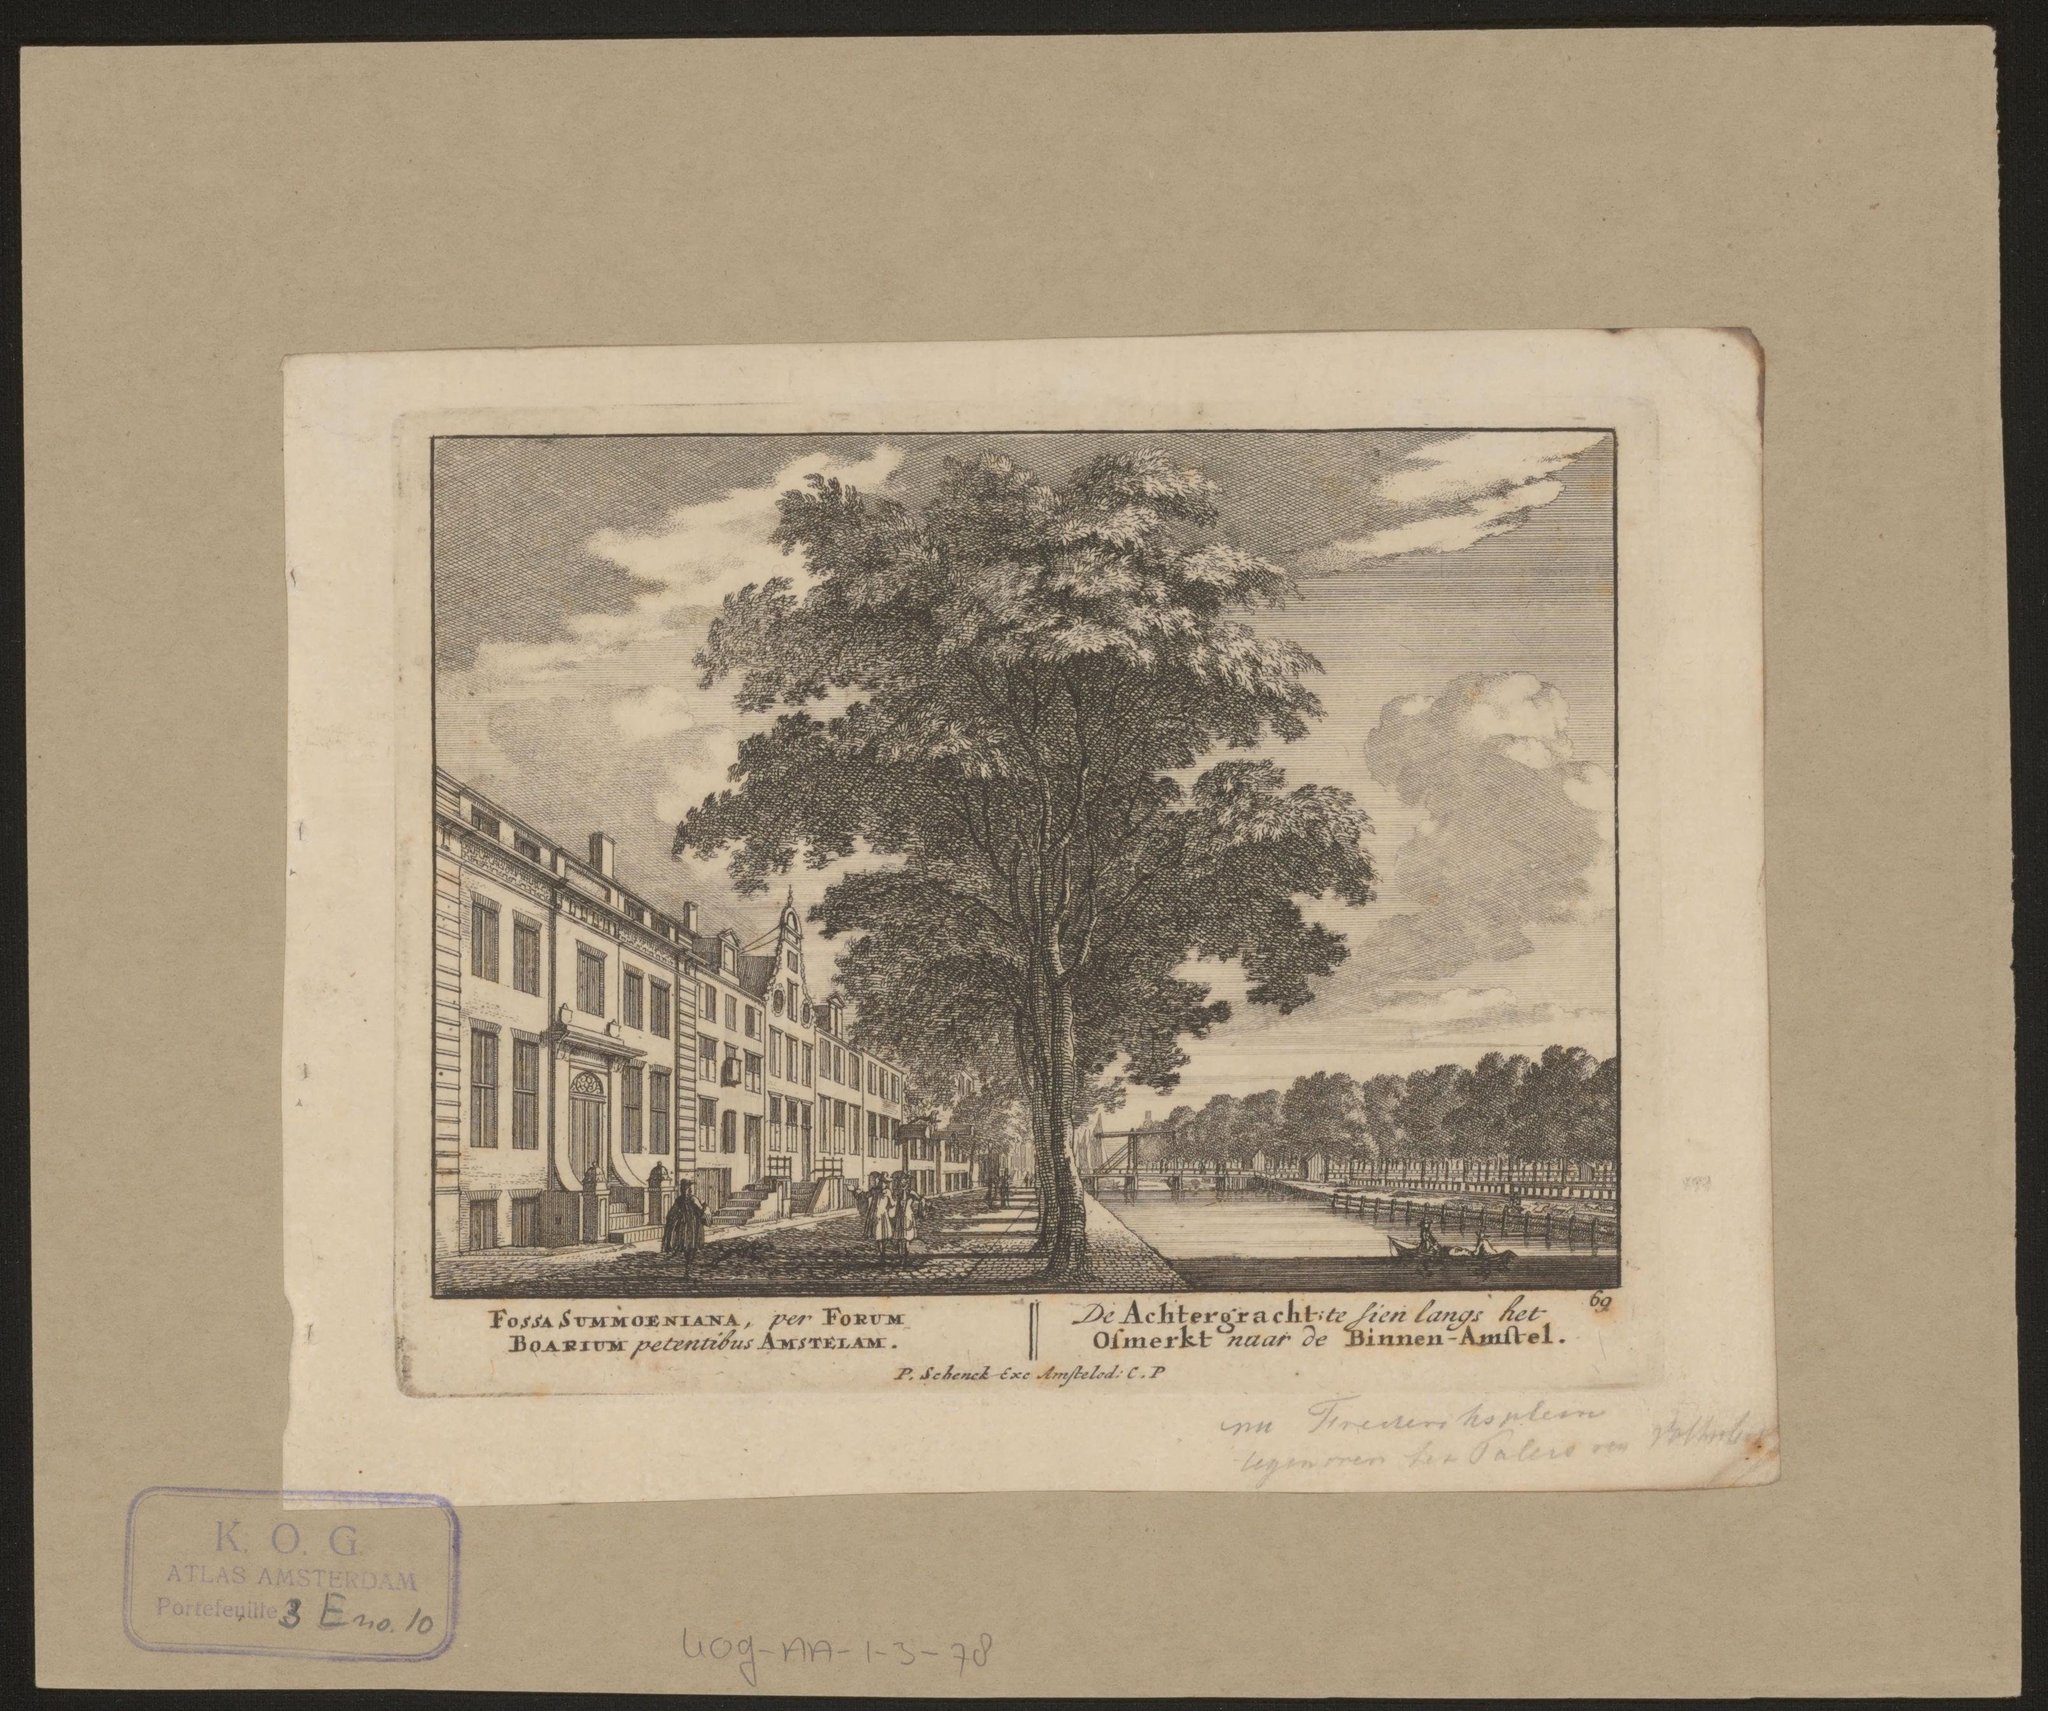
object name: print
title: Gezicht op de Achtergracht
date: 1700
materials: paper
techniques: etching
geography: amsterdam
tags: city-view in general; 'veduta', canal, the usual house or row of houses, bridge in city across river, canal, etc., street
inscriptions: inscription: ‘nu Frederiksplein / tegenover het Paleis voor Volksvlijt’, collector's mark: ‘3E no 10’ Lugt 1641b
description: Andere staat ook gebruikt in: Call, Jan van. Admirandorum Quadruplex Spectaculum. Amsterdam: Pieter Schenk (I), 1700. De titelprent, opdracht en het portret van Frederik van Saksen zijn gegraveerd door Pieter Schenk (I). De overige prenten uit deze serie zijn, zoals aangegeven op de titelprent, van de hand van Jan van Call (I).